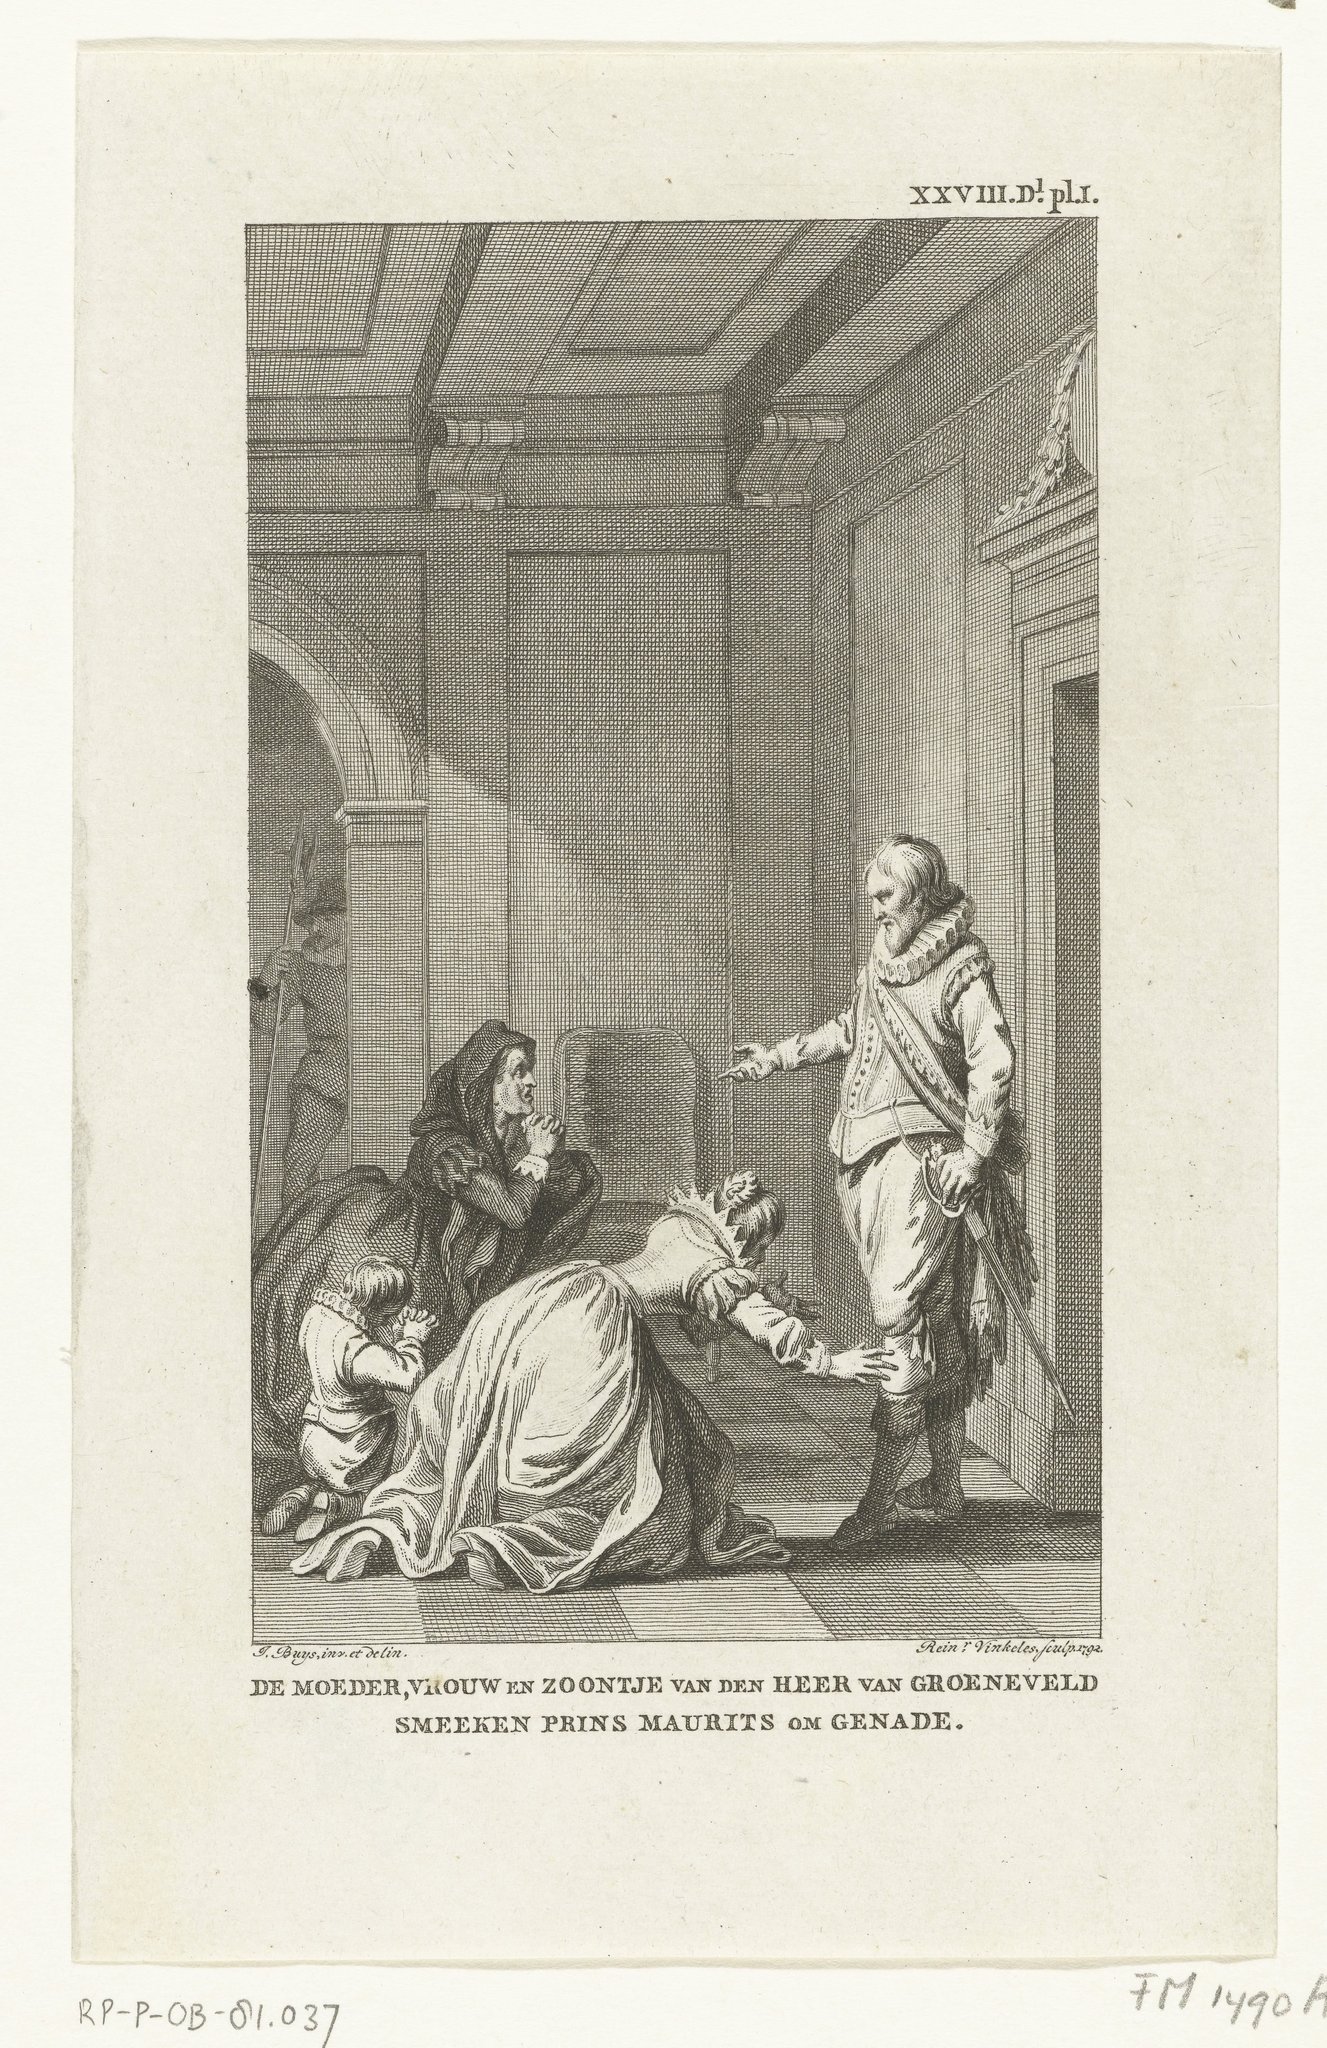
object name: print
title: De moeder, vrouw en zoon van Reinier van Oldenbarnevelt smeken Maurits om genade, 1623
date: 1792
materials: paper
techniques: etching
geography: netherlands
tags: the hague, maurice (prince of orange), (revolutionary) plot, conspiracy, granting mercy; free pardon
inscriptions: date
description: In een interieur knielen de moeder, vrouw en zoon van Reinier van Oldenbarnevelt aan de voeten van de prins en smeken Maurits om genade voor Reinier van Oldenbarnevelt, één van de ter dood veroordeelde samenzweerders, maart 1623.